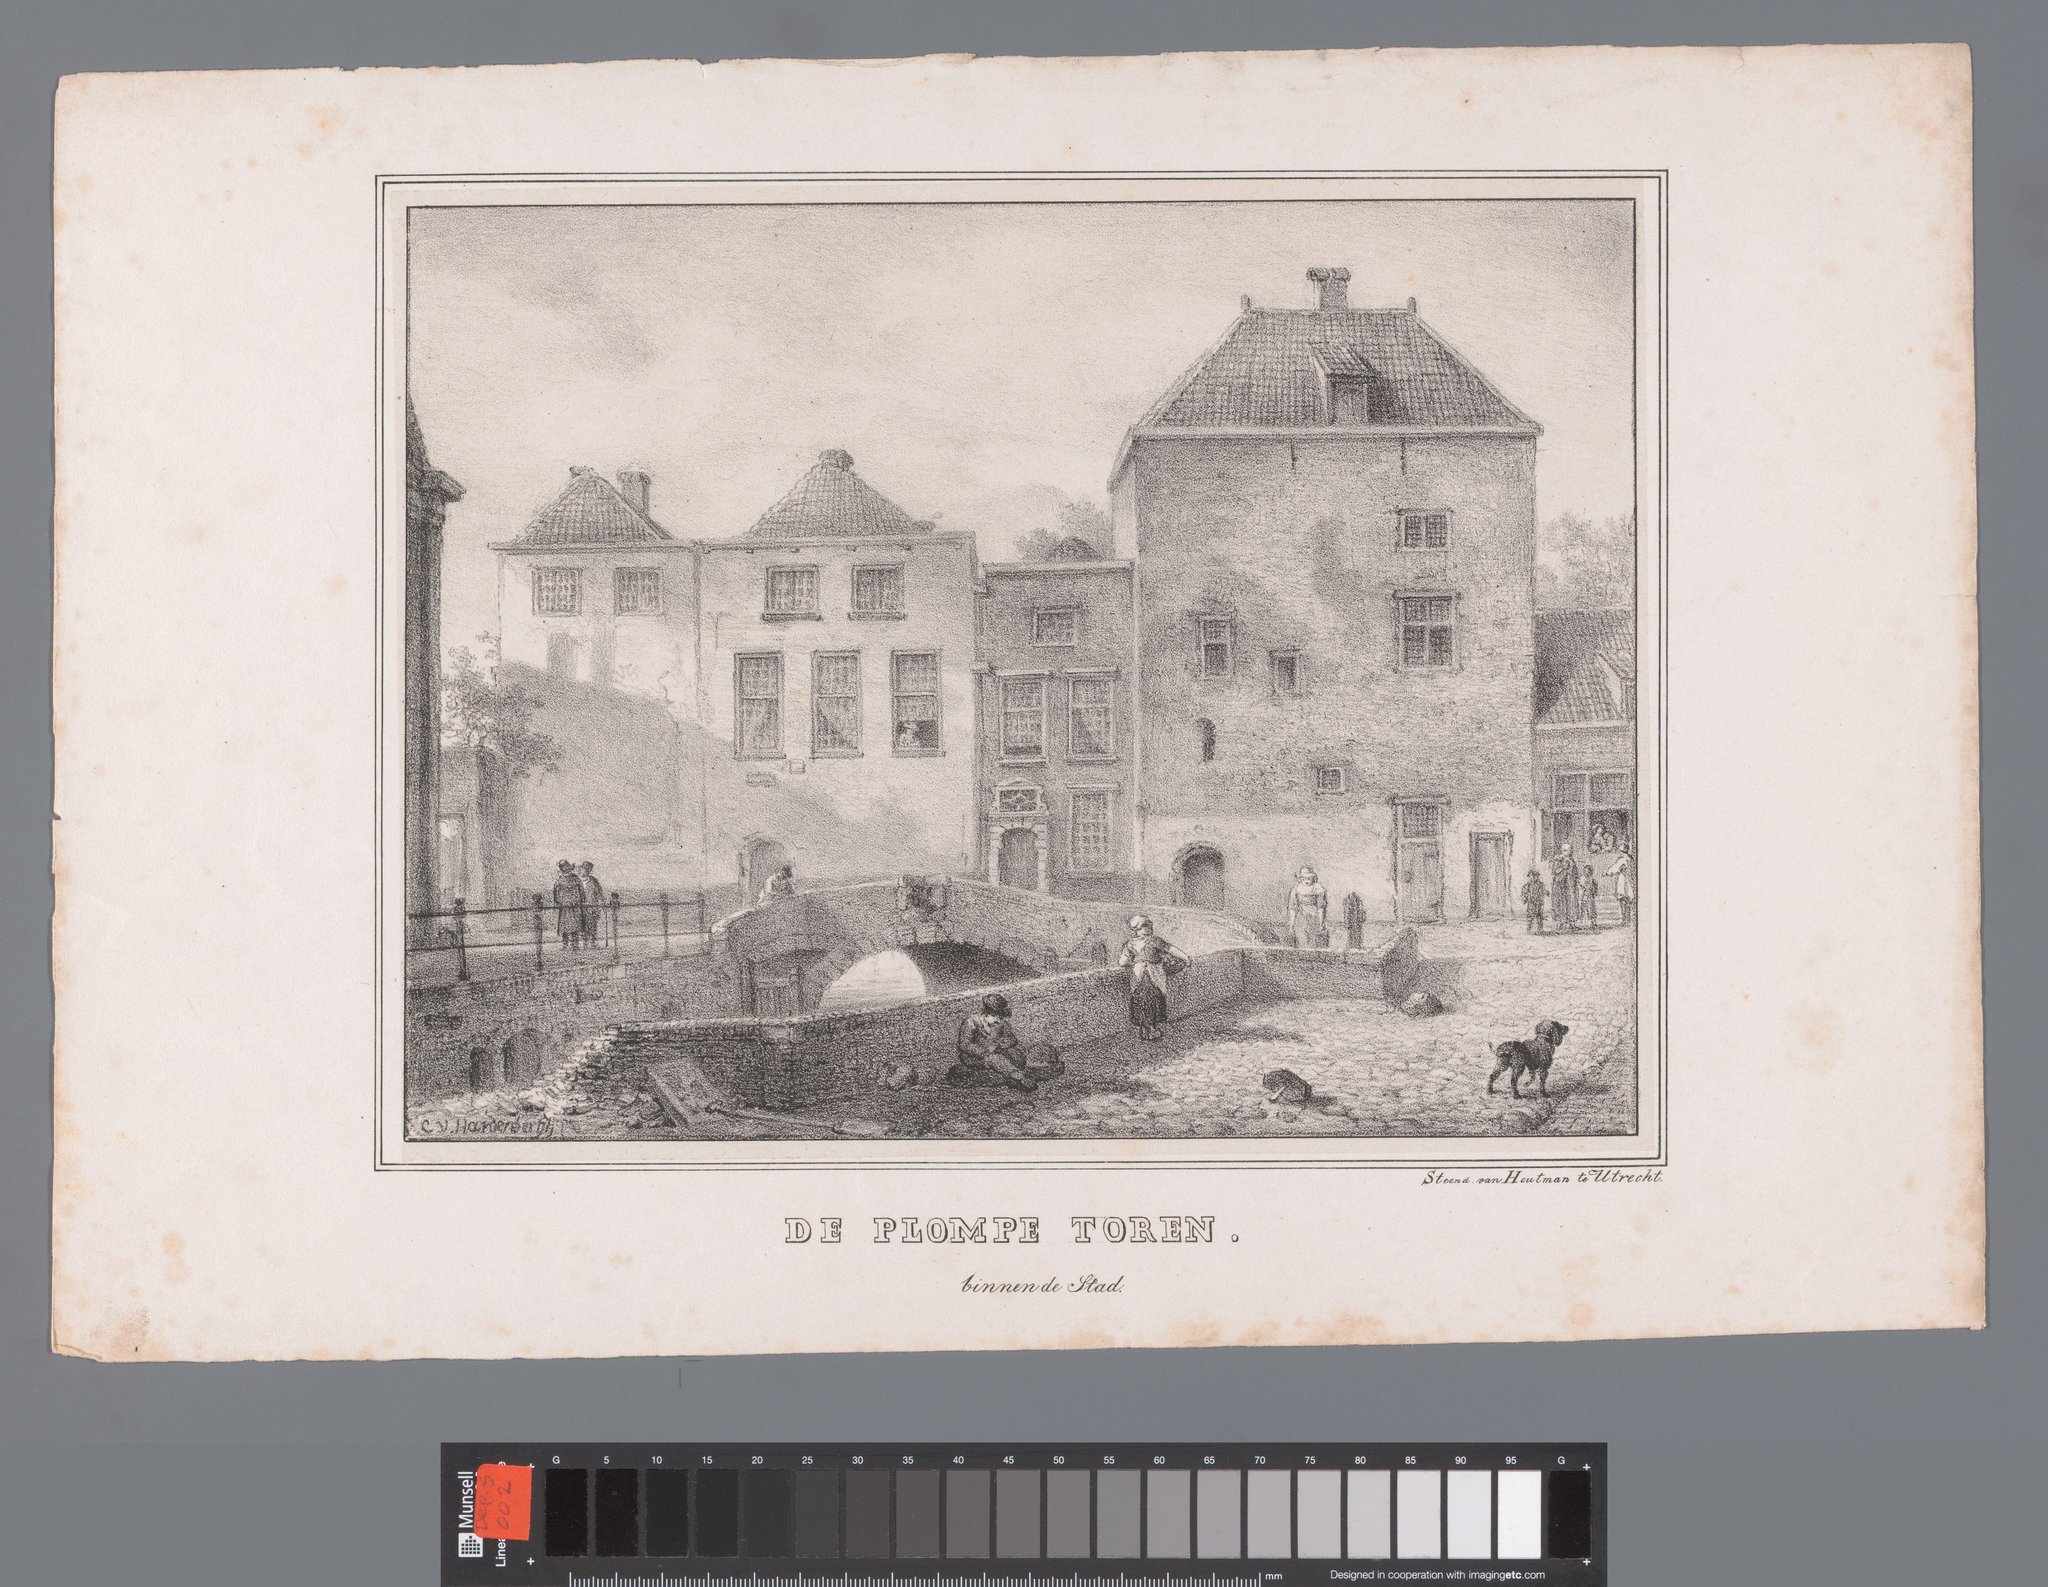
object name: print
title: Afbeeldingen van gezichten te of bij Utrecht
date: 1809-1843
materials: paper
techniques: lithograph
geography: utrecht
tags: brick-layer at work, canals, waters (in city), utrecht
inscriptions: collector's mark: Lugt 2228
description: De muur rond de gracht is nog in aanbouw. Maakt deel uit van een omslag met vijftien prentne.